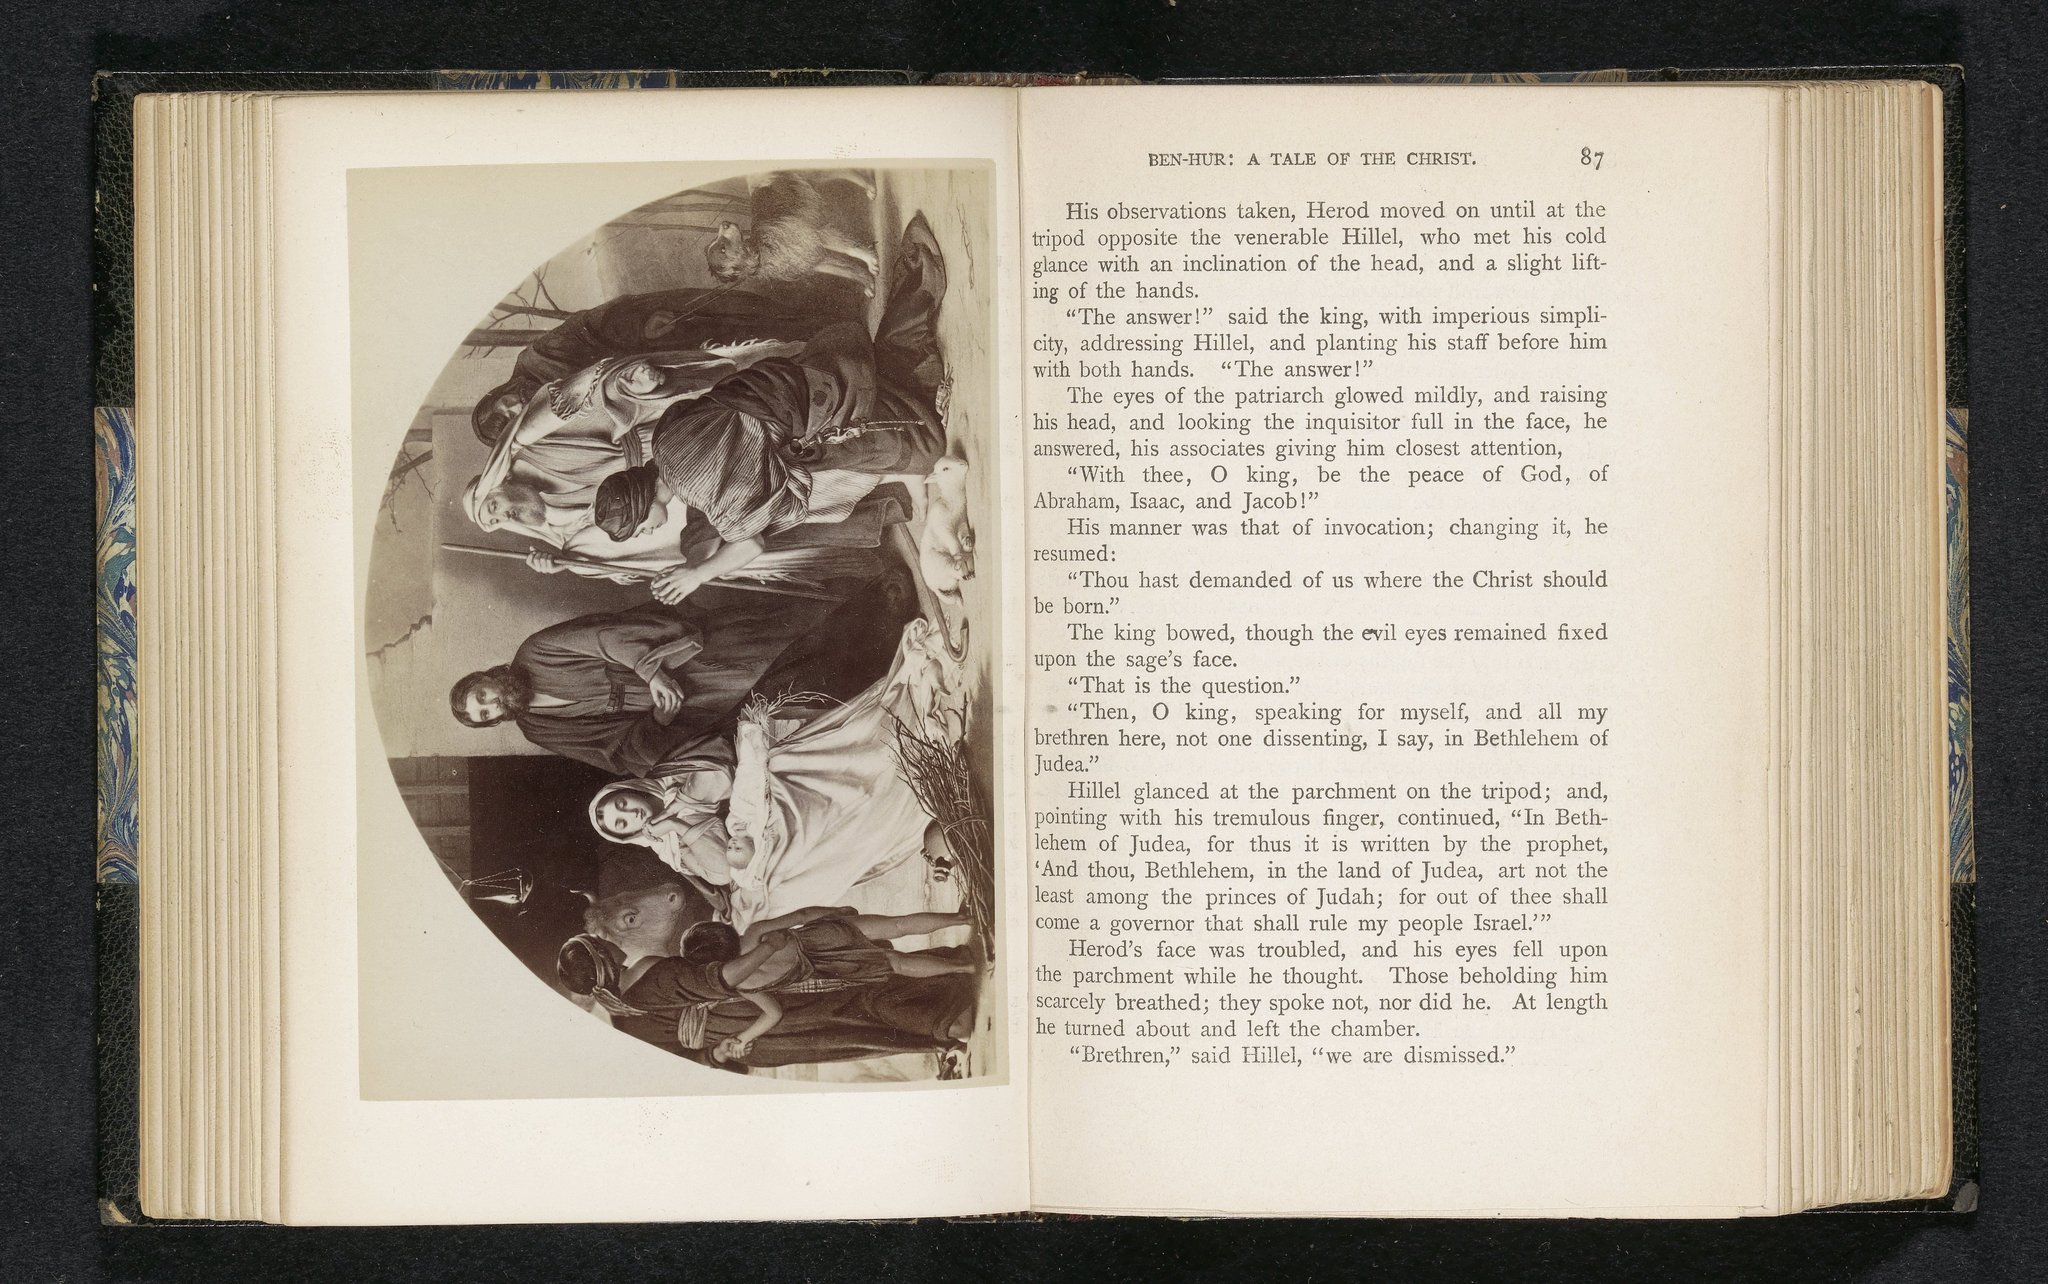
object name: photograph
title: Fotoreproductie van een schilderij, voorstellende de aanbidding der herders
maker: Anonymous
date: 1883-1888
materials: photographic support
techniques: albumen print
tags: adoration of the christ-child by the shepherds; mary and joseph present